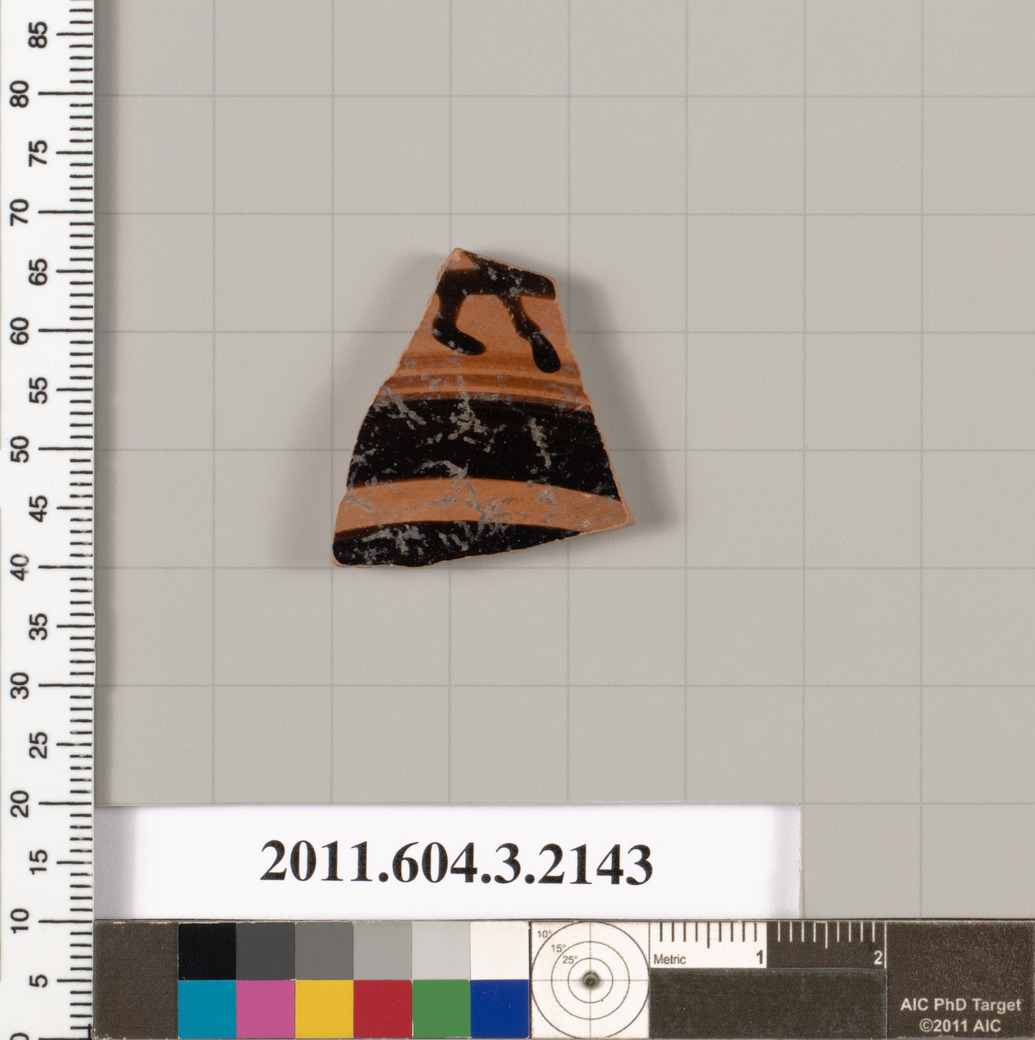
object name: kylix fragment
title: Terracotta fragment of a kylix (drinking cup)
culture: greek, attic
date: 534-468 BCE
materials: terracotta